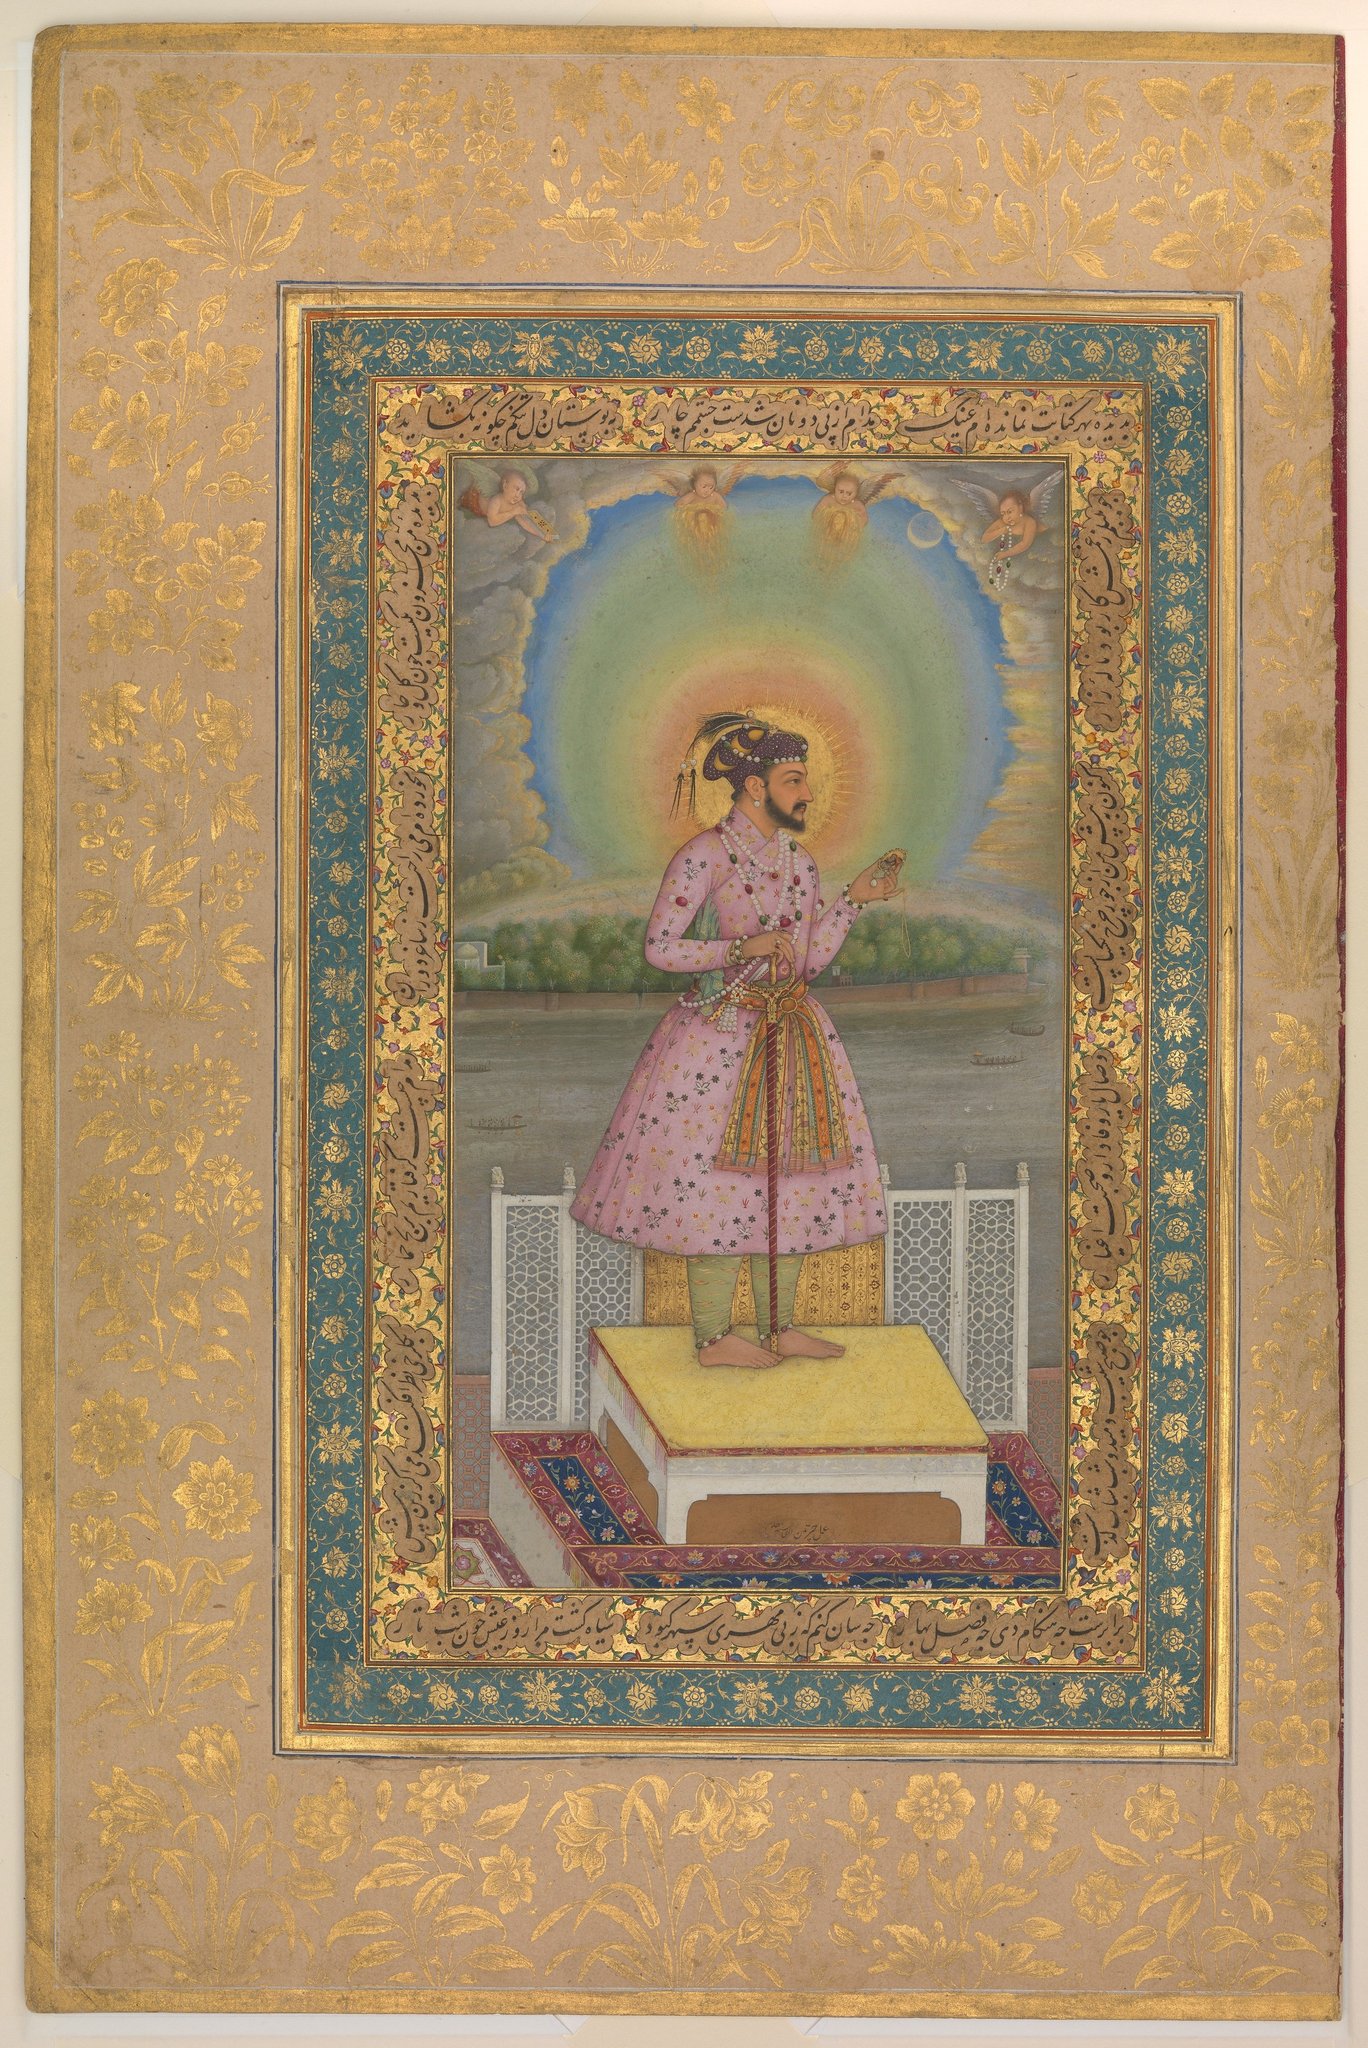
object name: album leaf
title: "Shah Jahan on a Terrace, Holding a Pendant Set With His Portrait", Folio from the Shah Jahan Album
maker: chitarman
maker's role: artist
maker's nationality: indian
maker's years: 1627-1670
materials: gold, ink, paper, watercolor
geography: india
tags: men,portraits